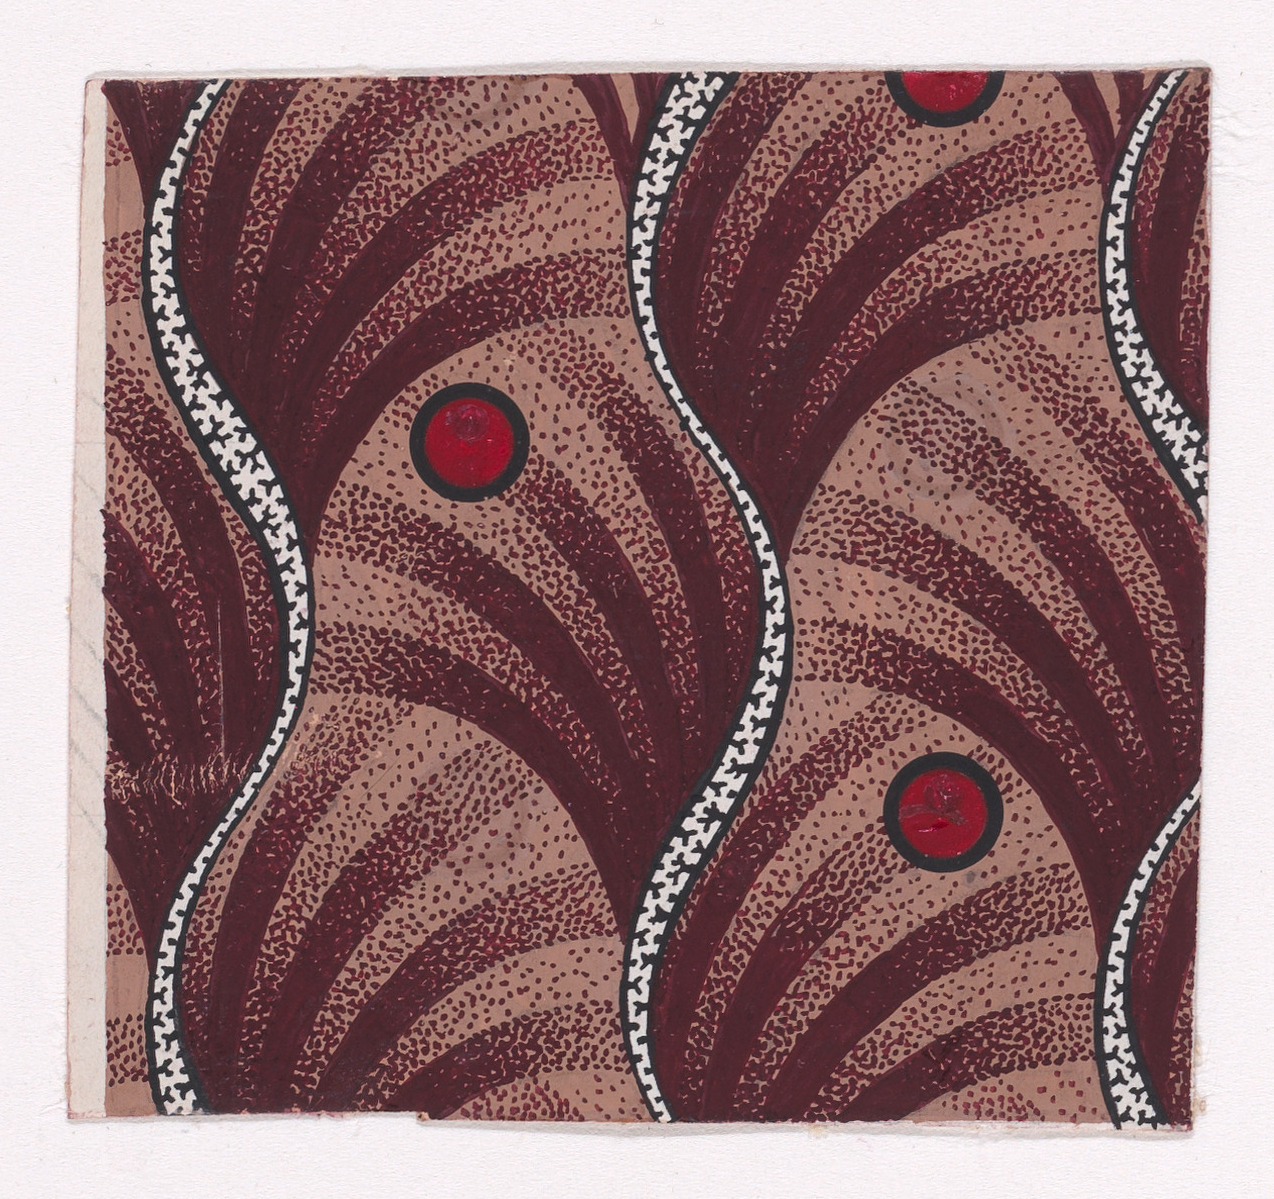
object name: drawing ornament architecture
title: Textile Design with Alternating Vertical Stripes of Undulating Ribbons Outlined with Branches and Circles Over a Background of Shifting Scales with Stripes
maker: anonymous, alsatian, 19th century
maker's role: artist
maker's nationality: alsatian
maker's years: 1800-1900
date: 1840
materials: gouache